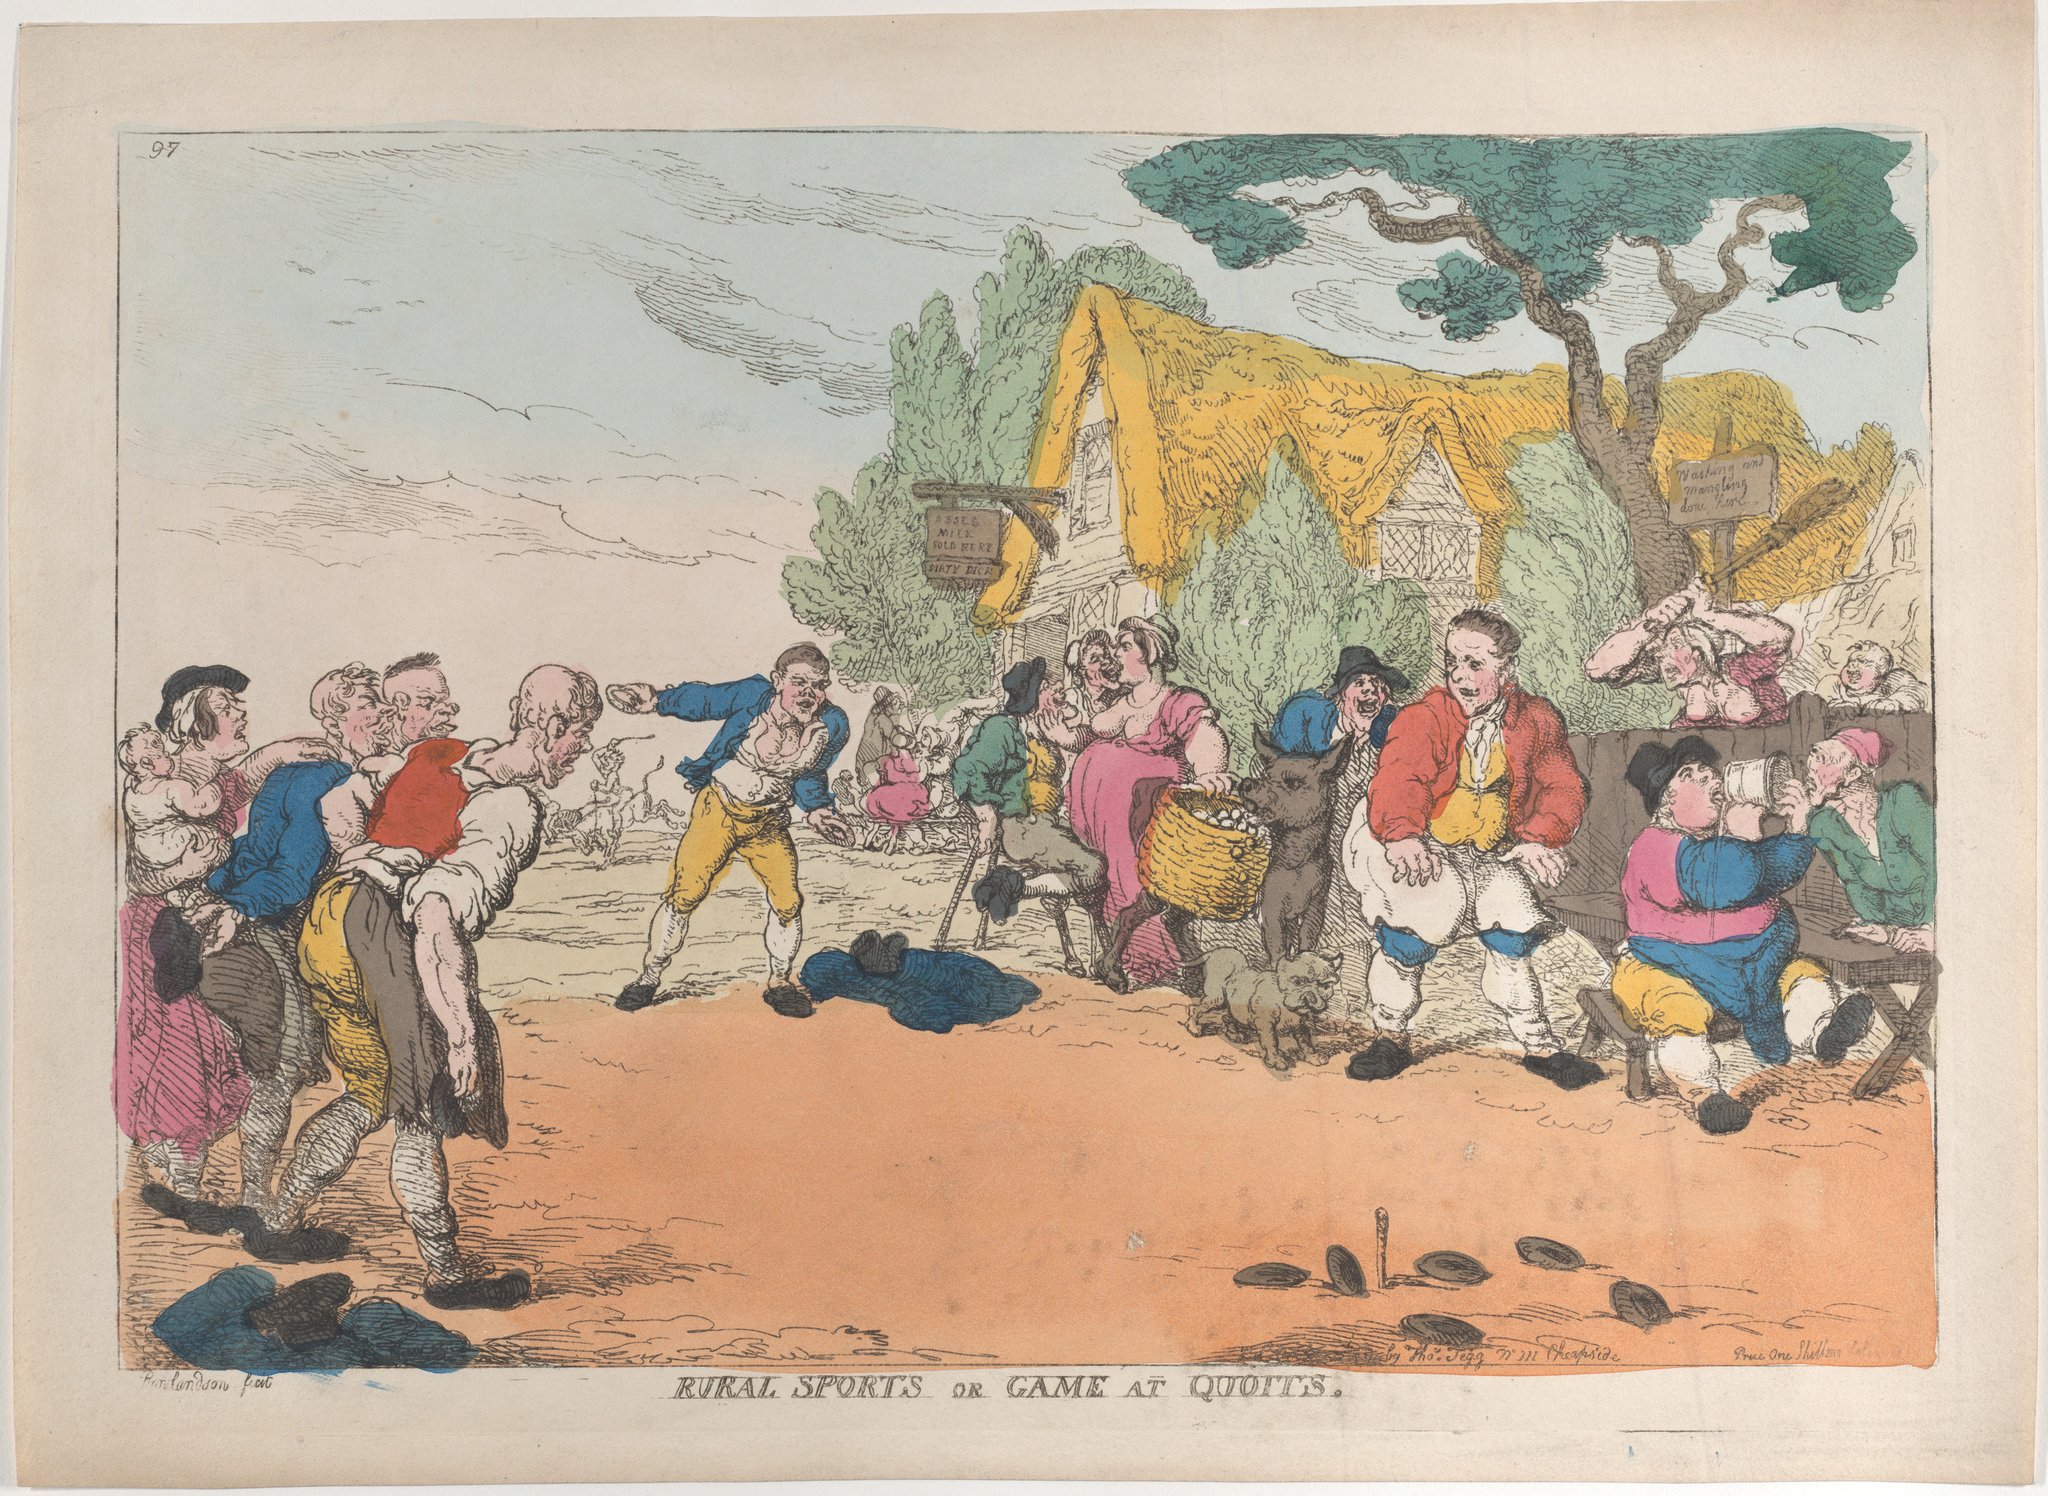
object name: print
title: Rural Sports or Game at Quoits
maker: thomas rowlandson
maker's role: artist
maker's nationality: british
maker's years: 1757-1827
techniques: etching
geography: london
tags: satire,villages,men,women,games